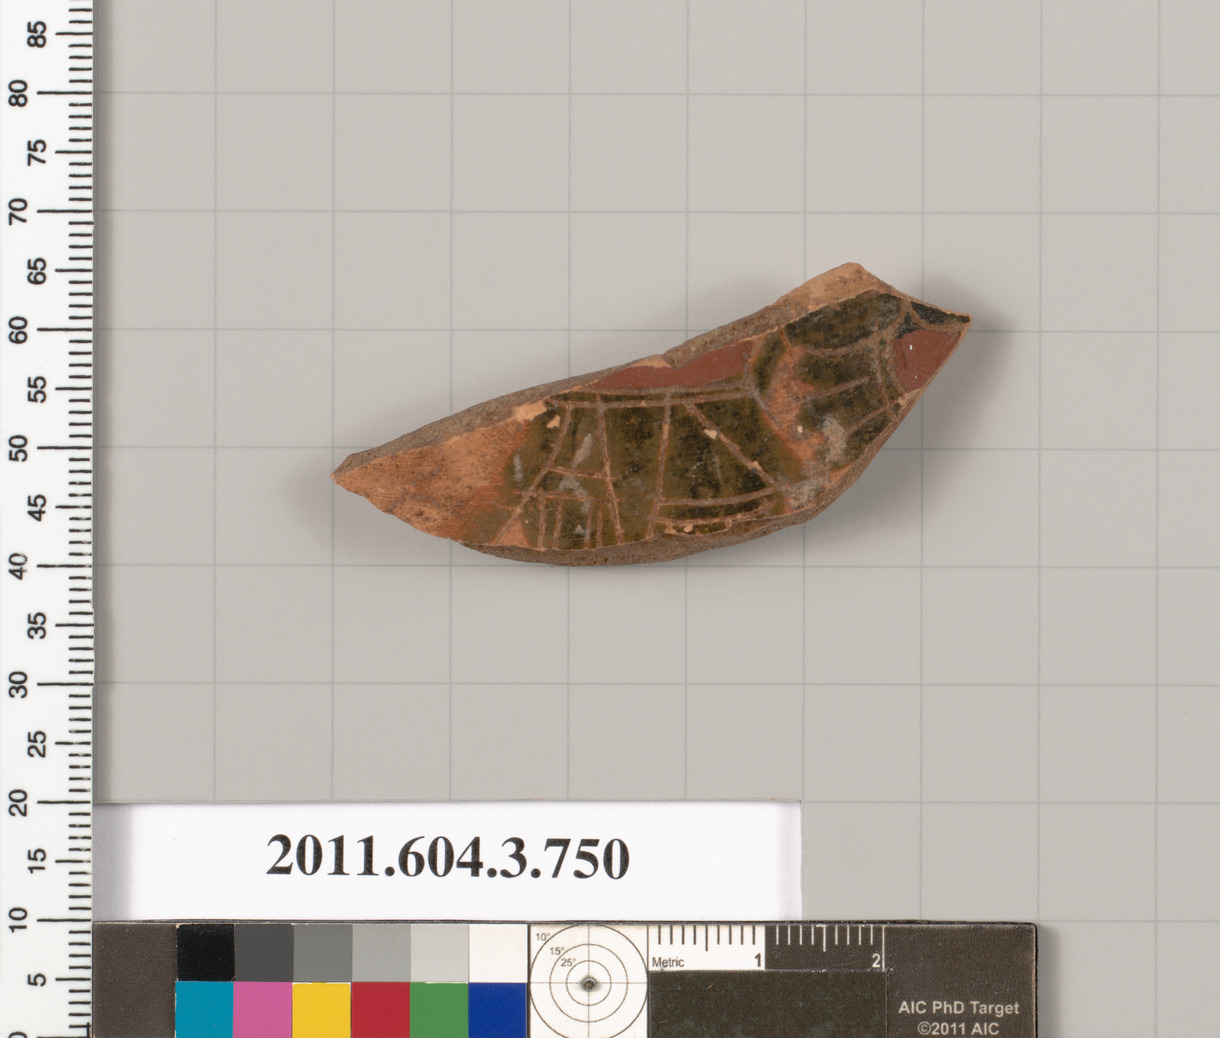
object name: neck amphora, tyrrhenian fragment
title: Terracotta fragment of a neck-amphora (jar)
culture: greek, attic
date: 575-551 BCE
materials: terracotta